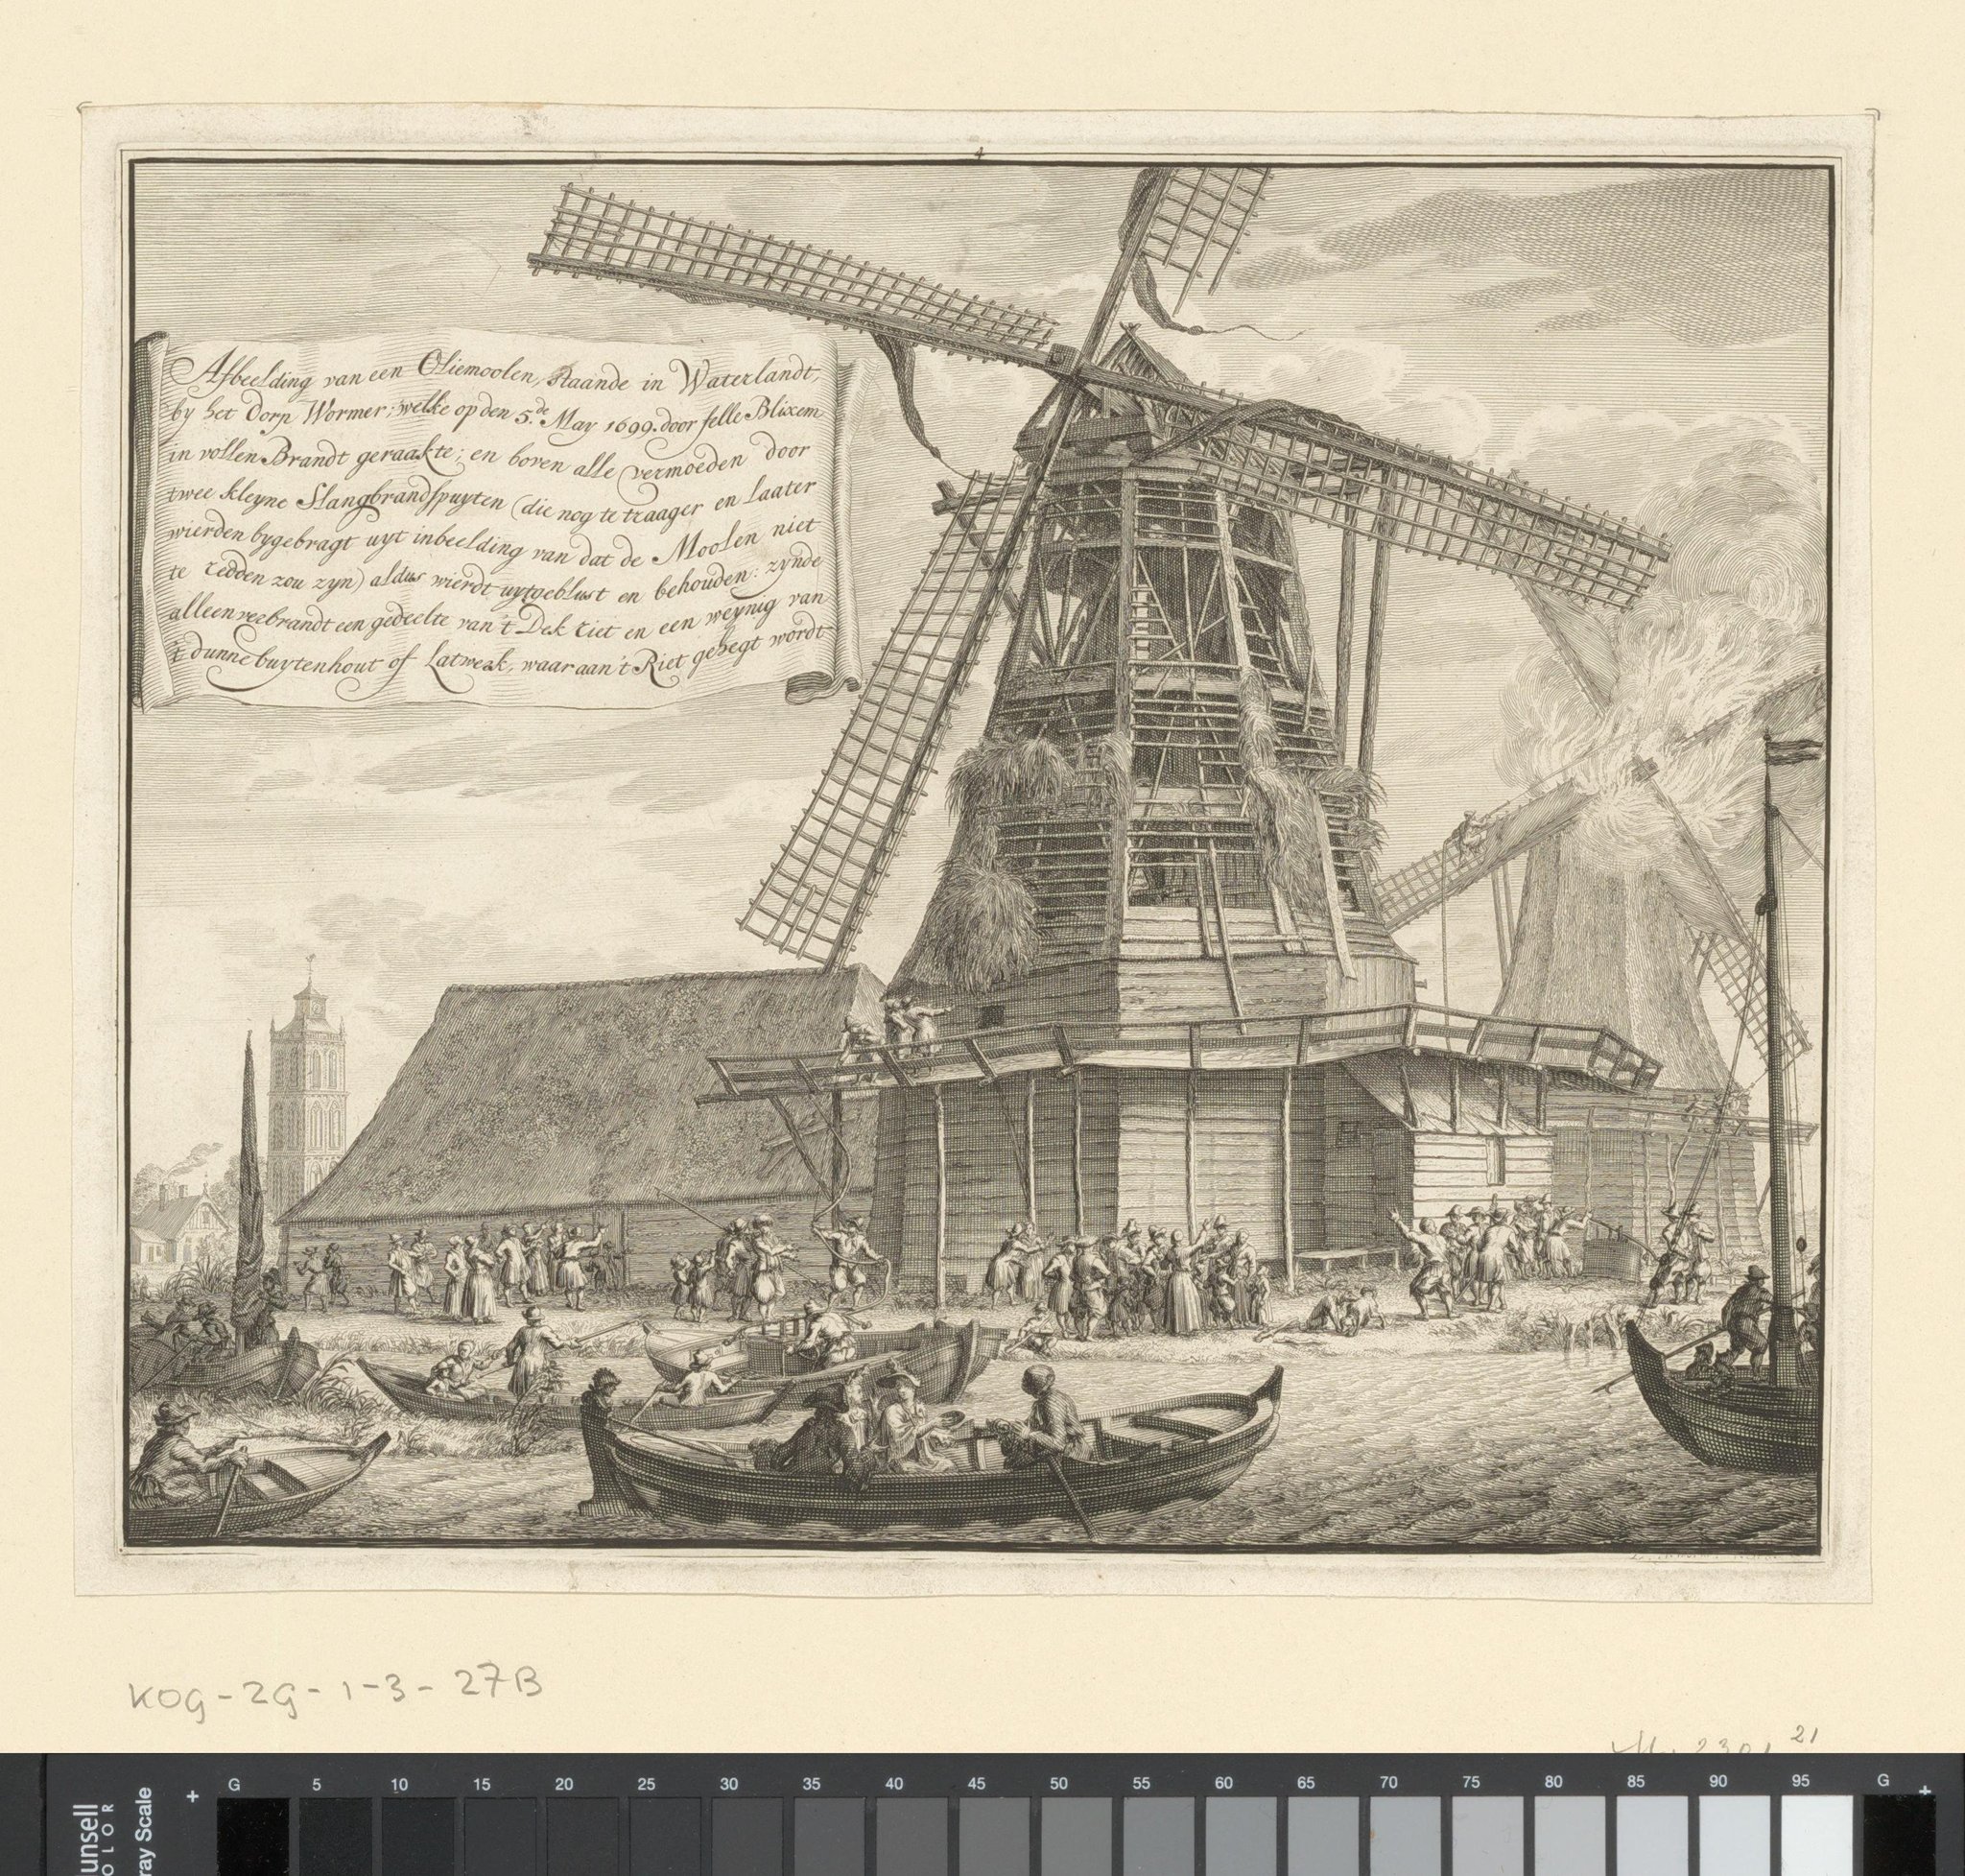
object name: book illustration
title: Brand in oliemolen De Zeug bij Wormer, 1699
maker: laurens scherm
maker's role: draughtsman, print maker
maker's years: 1671-1702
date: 1735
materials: paper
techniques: engraving, etching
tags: on fire, ablaze, windmill in landscape, fire-extinguishing equipment, ruin of a dwelling, house, castle, etc., amsterdam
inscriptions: collector's mark: Lugt 1641, stamp, stamp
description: Zicht op oliemolens De Keizer (voorgrond) en De Zeug (achtergrond) bij Wormer. Oliemolen De Zeug werd op 5 mei 1699 getroffen door de bliksem en vatte vlam. Van oliemolen De Keizer is uit voorzorg het rietdek verwijderd om brand door overwaaiende vonken te voorkomen. Door het blussen met een slangbrandspuit is De Zeug grotendeels bewaard gebleven. Linksboven een banderol met een opschrift. Onderwerpsrubrieken binnen de Atlas Zeden en Gewoonten: Regeering, Brandwezen.